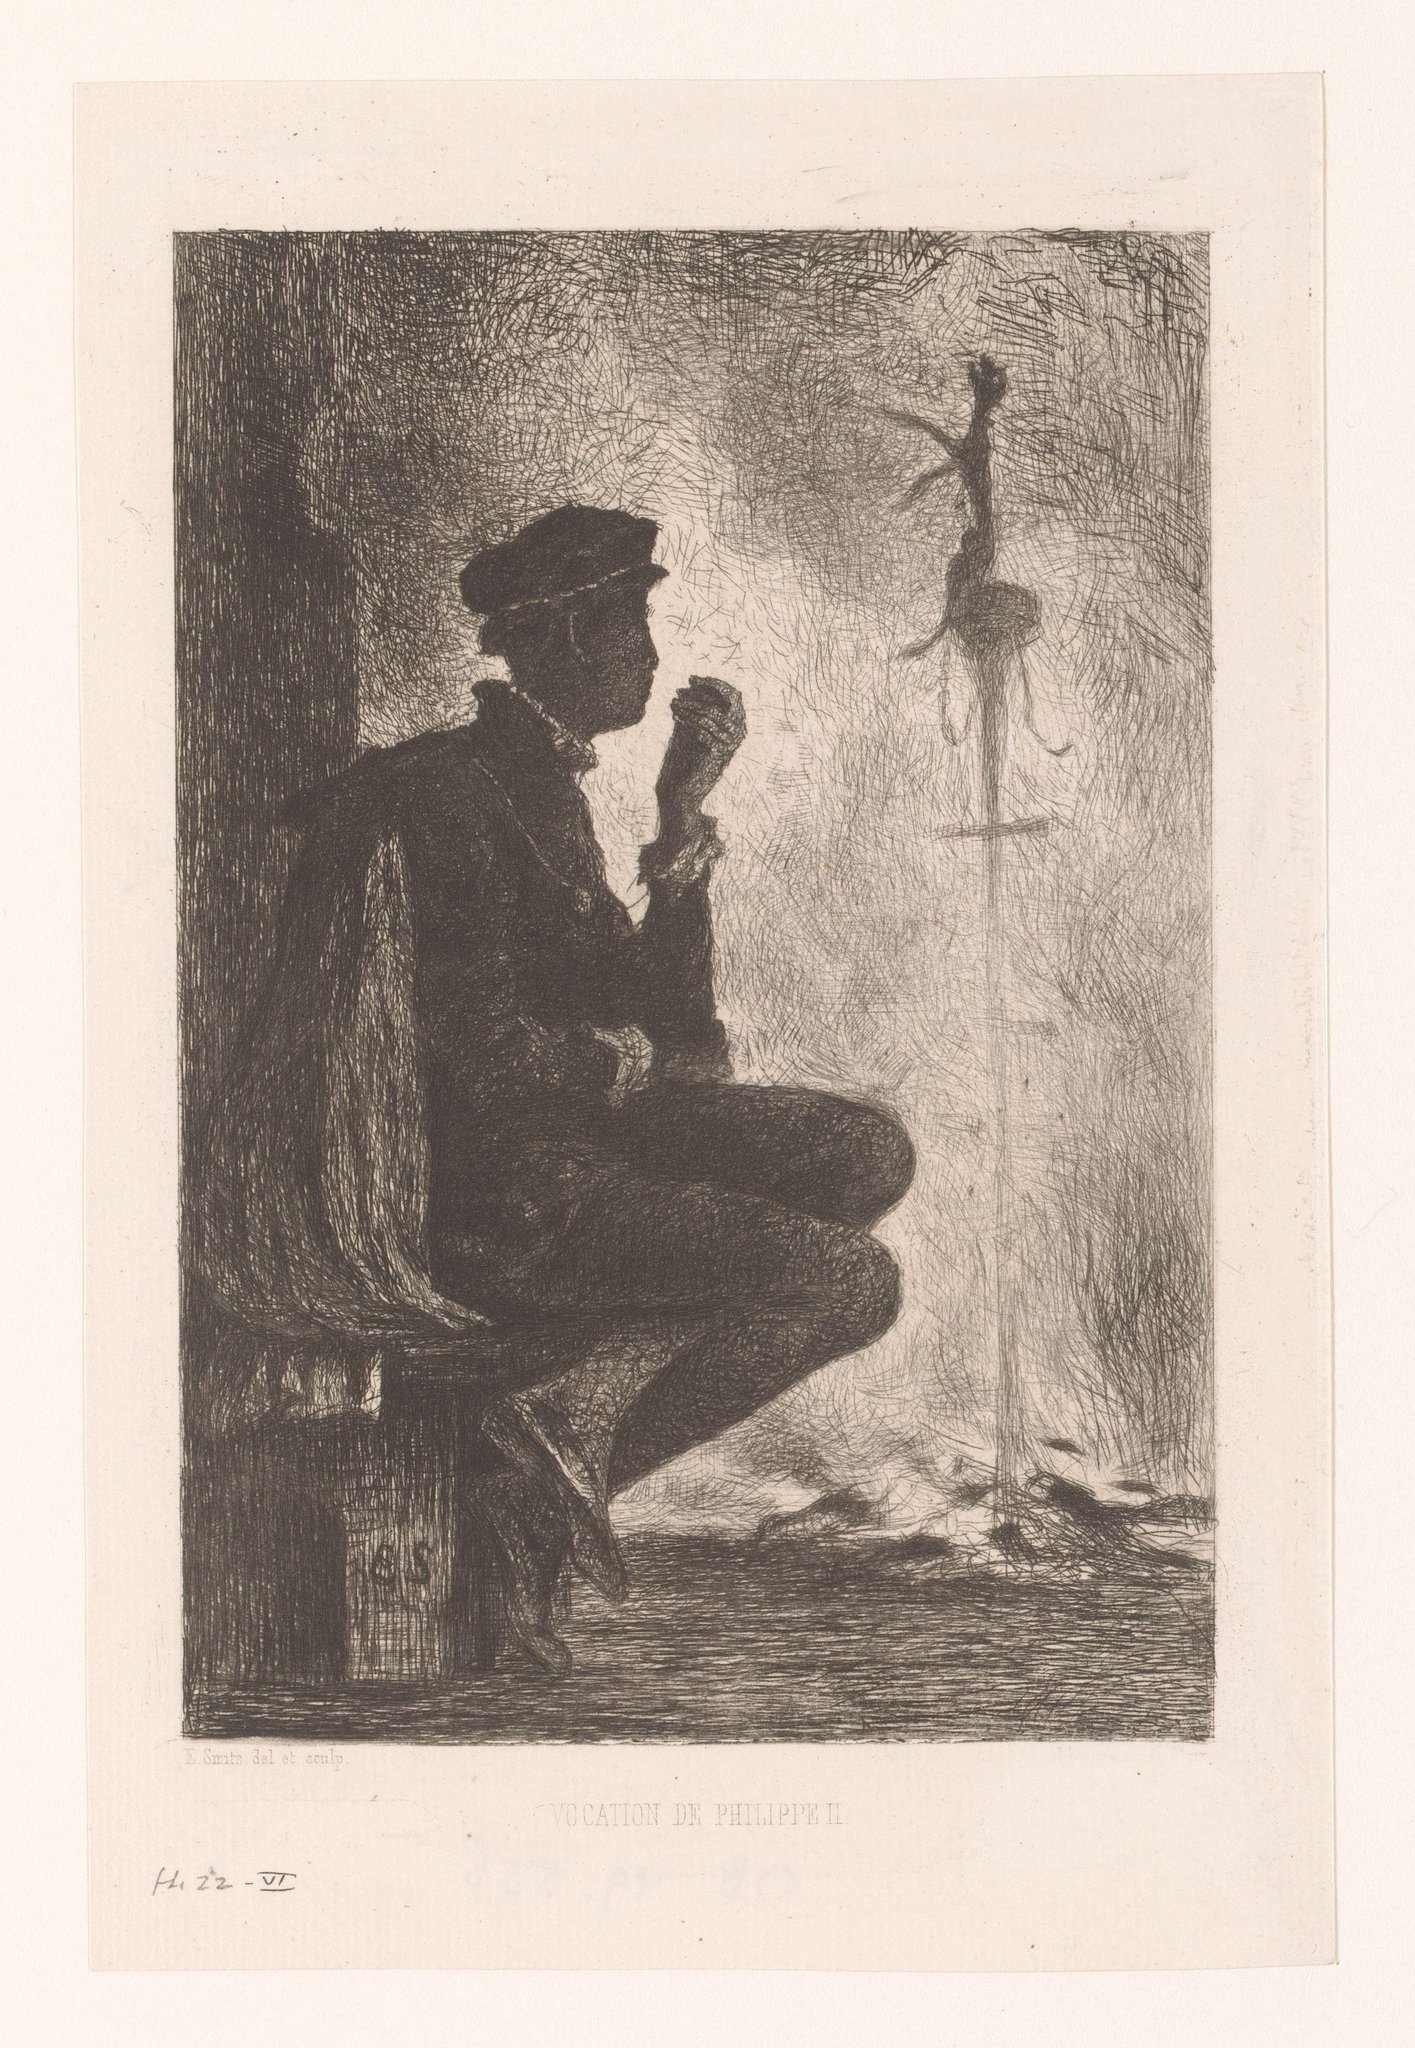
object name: book illustration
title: Vocation de Philippe II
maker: eugène smits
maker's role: painter, print maker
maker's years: 1826-1912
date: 1869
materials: paper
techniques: drypoint, etching, intaglio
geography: paris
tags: philip ii of spain, historical persons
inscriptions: collector's mark: Lugt 2227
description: Prent uit: Coster, Charles de. La légende et les aventures héroiques, joyeuses et glorieuses d'Ulenspiegel et de Lamme Goedzak au pays de Flandres et ailleurs. Tweede editie. Parijs: Librairie Internationale, 1869, p. 33. De vijfde staat wordt bij Hippert & Linnig beschreven als met adres van Bouwens. Dat is op dit exemplaar echter niet het geval. Voor de zesde staat wordt niet vermeld dat het adres van Bouwens weggehaald is. Het onderschrift komt echter overeen met dat voor de tweede editie van Uilenspiegel, zodat een vijfde of zesde staat waarschijnlijk is.